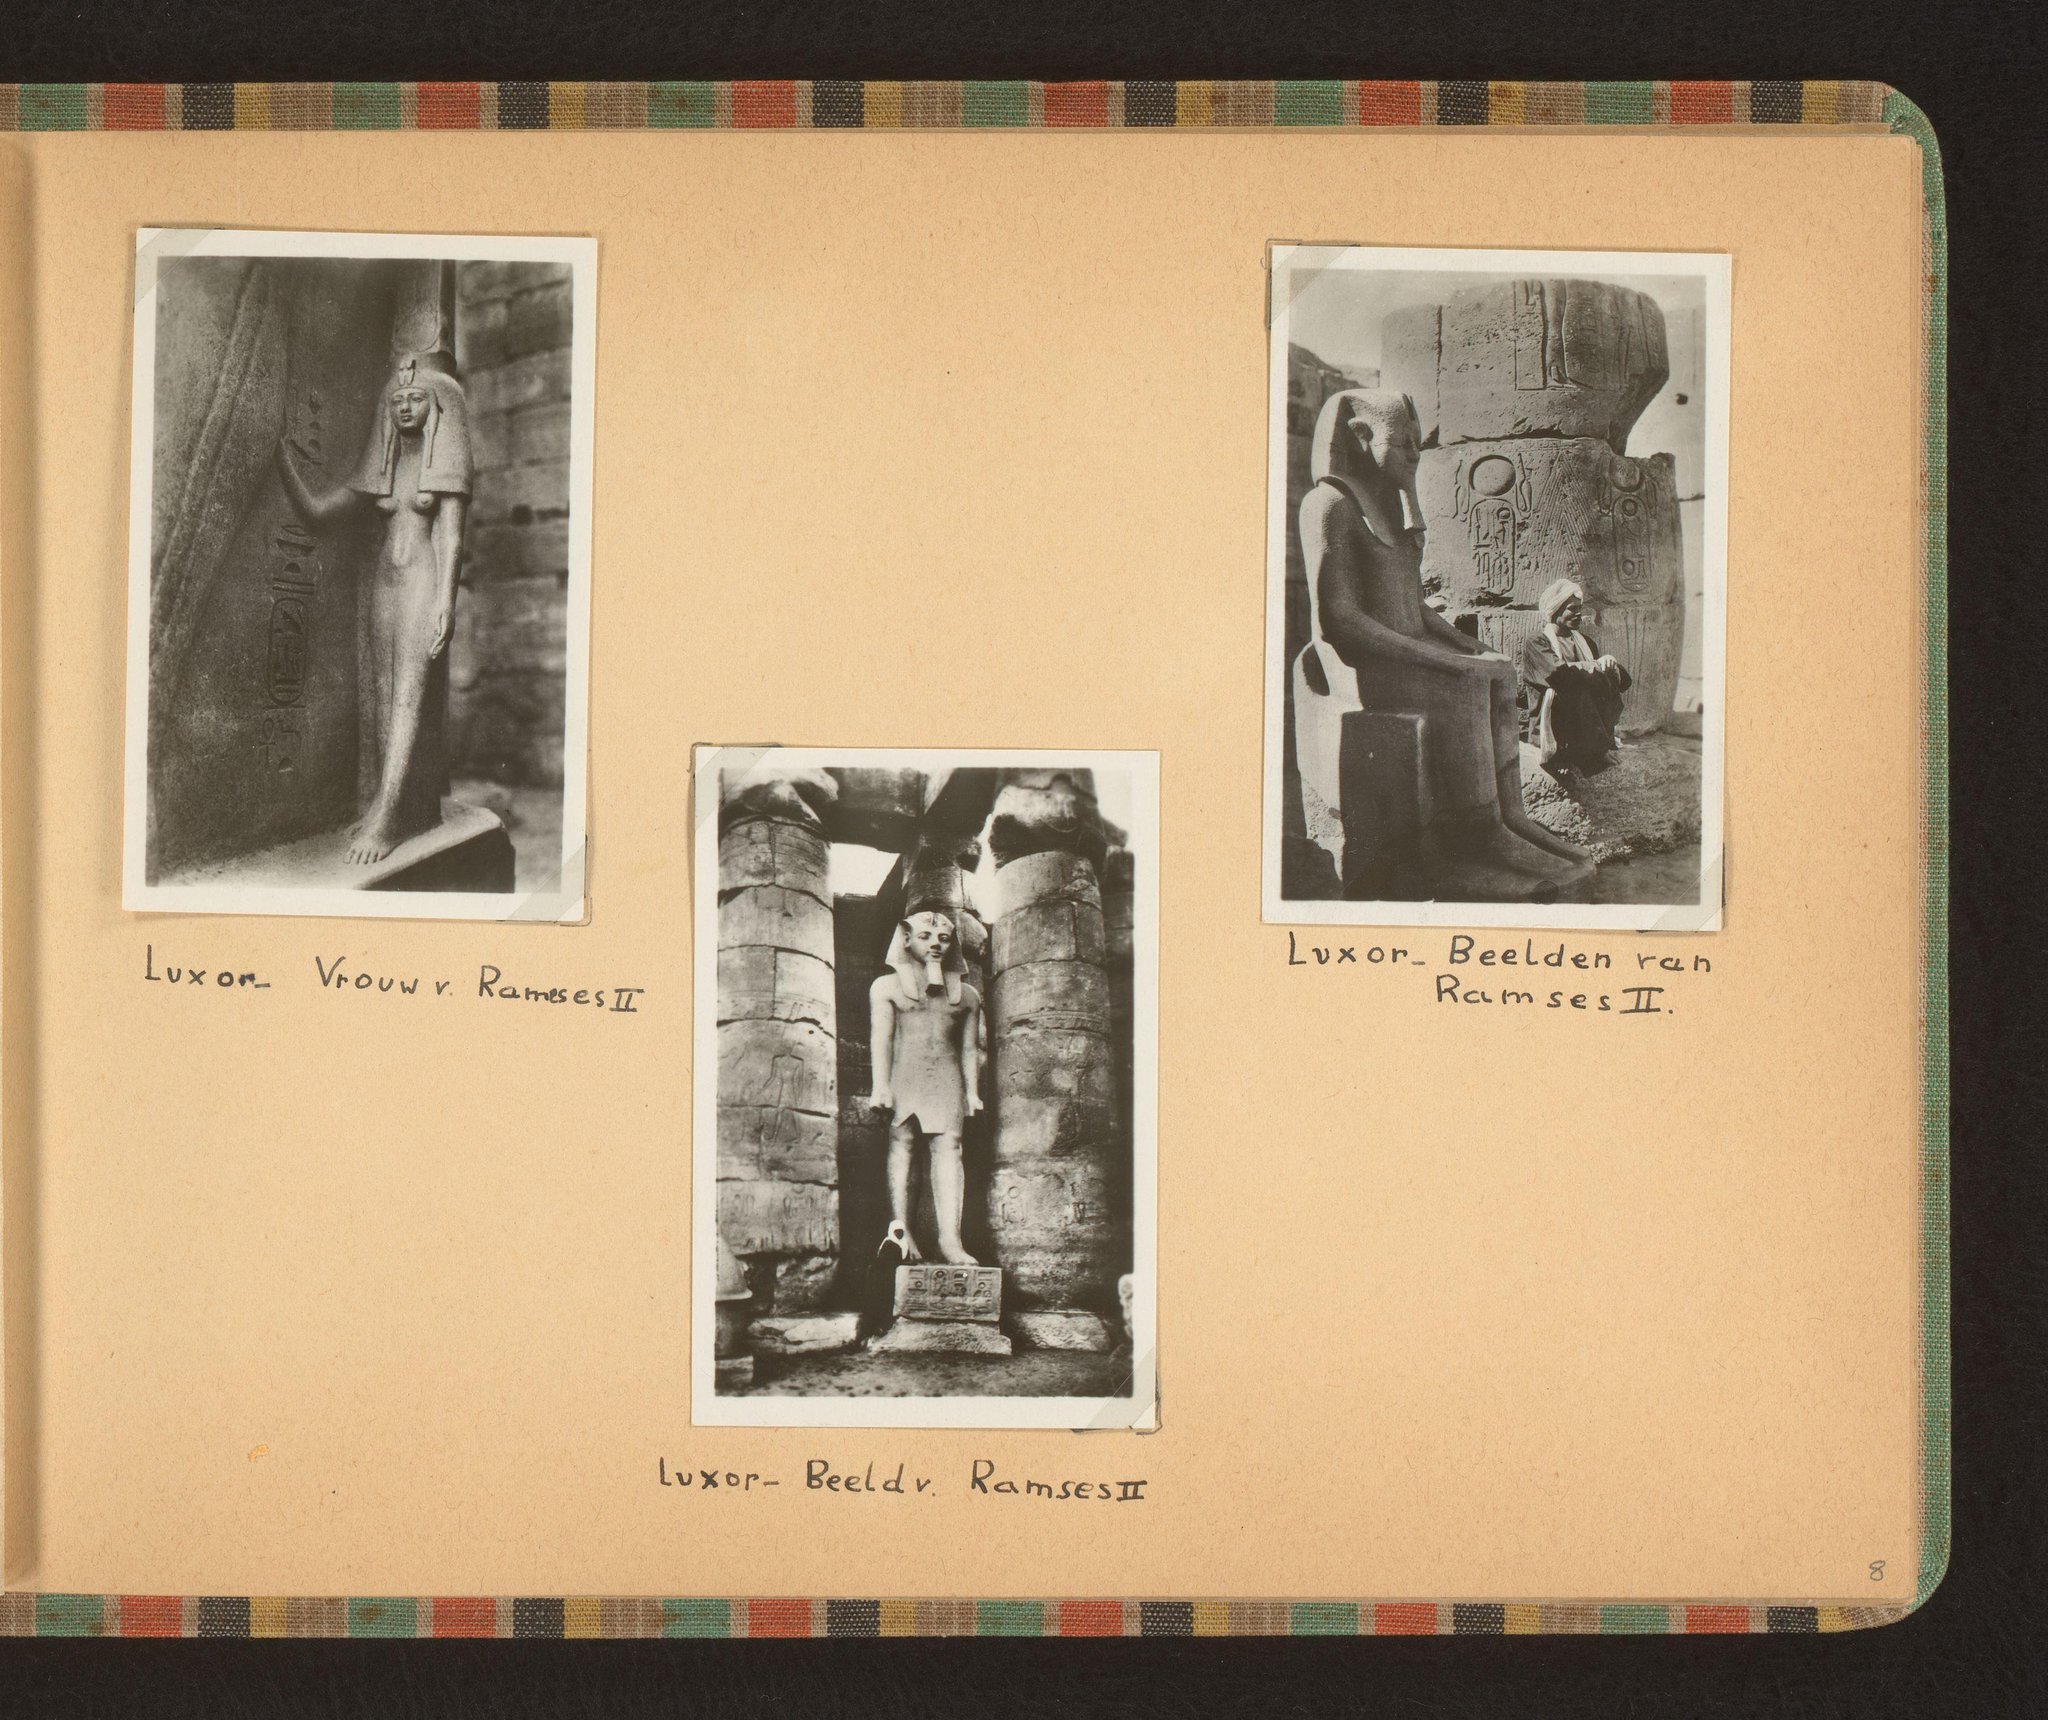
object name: photograph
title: Luxor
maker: Anonymous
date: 1936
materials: paper, photographic support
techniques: gelatin silver print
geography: egypt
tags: tourism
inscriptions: inscription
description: Albumblad met drie foto's van standbeelden van Ramses II in de Luxortempel. Alle foto's met onderschriften. Onderdeel van een album over een vakantiereis over de Nijl in 1936.